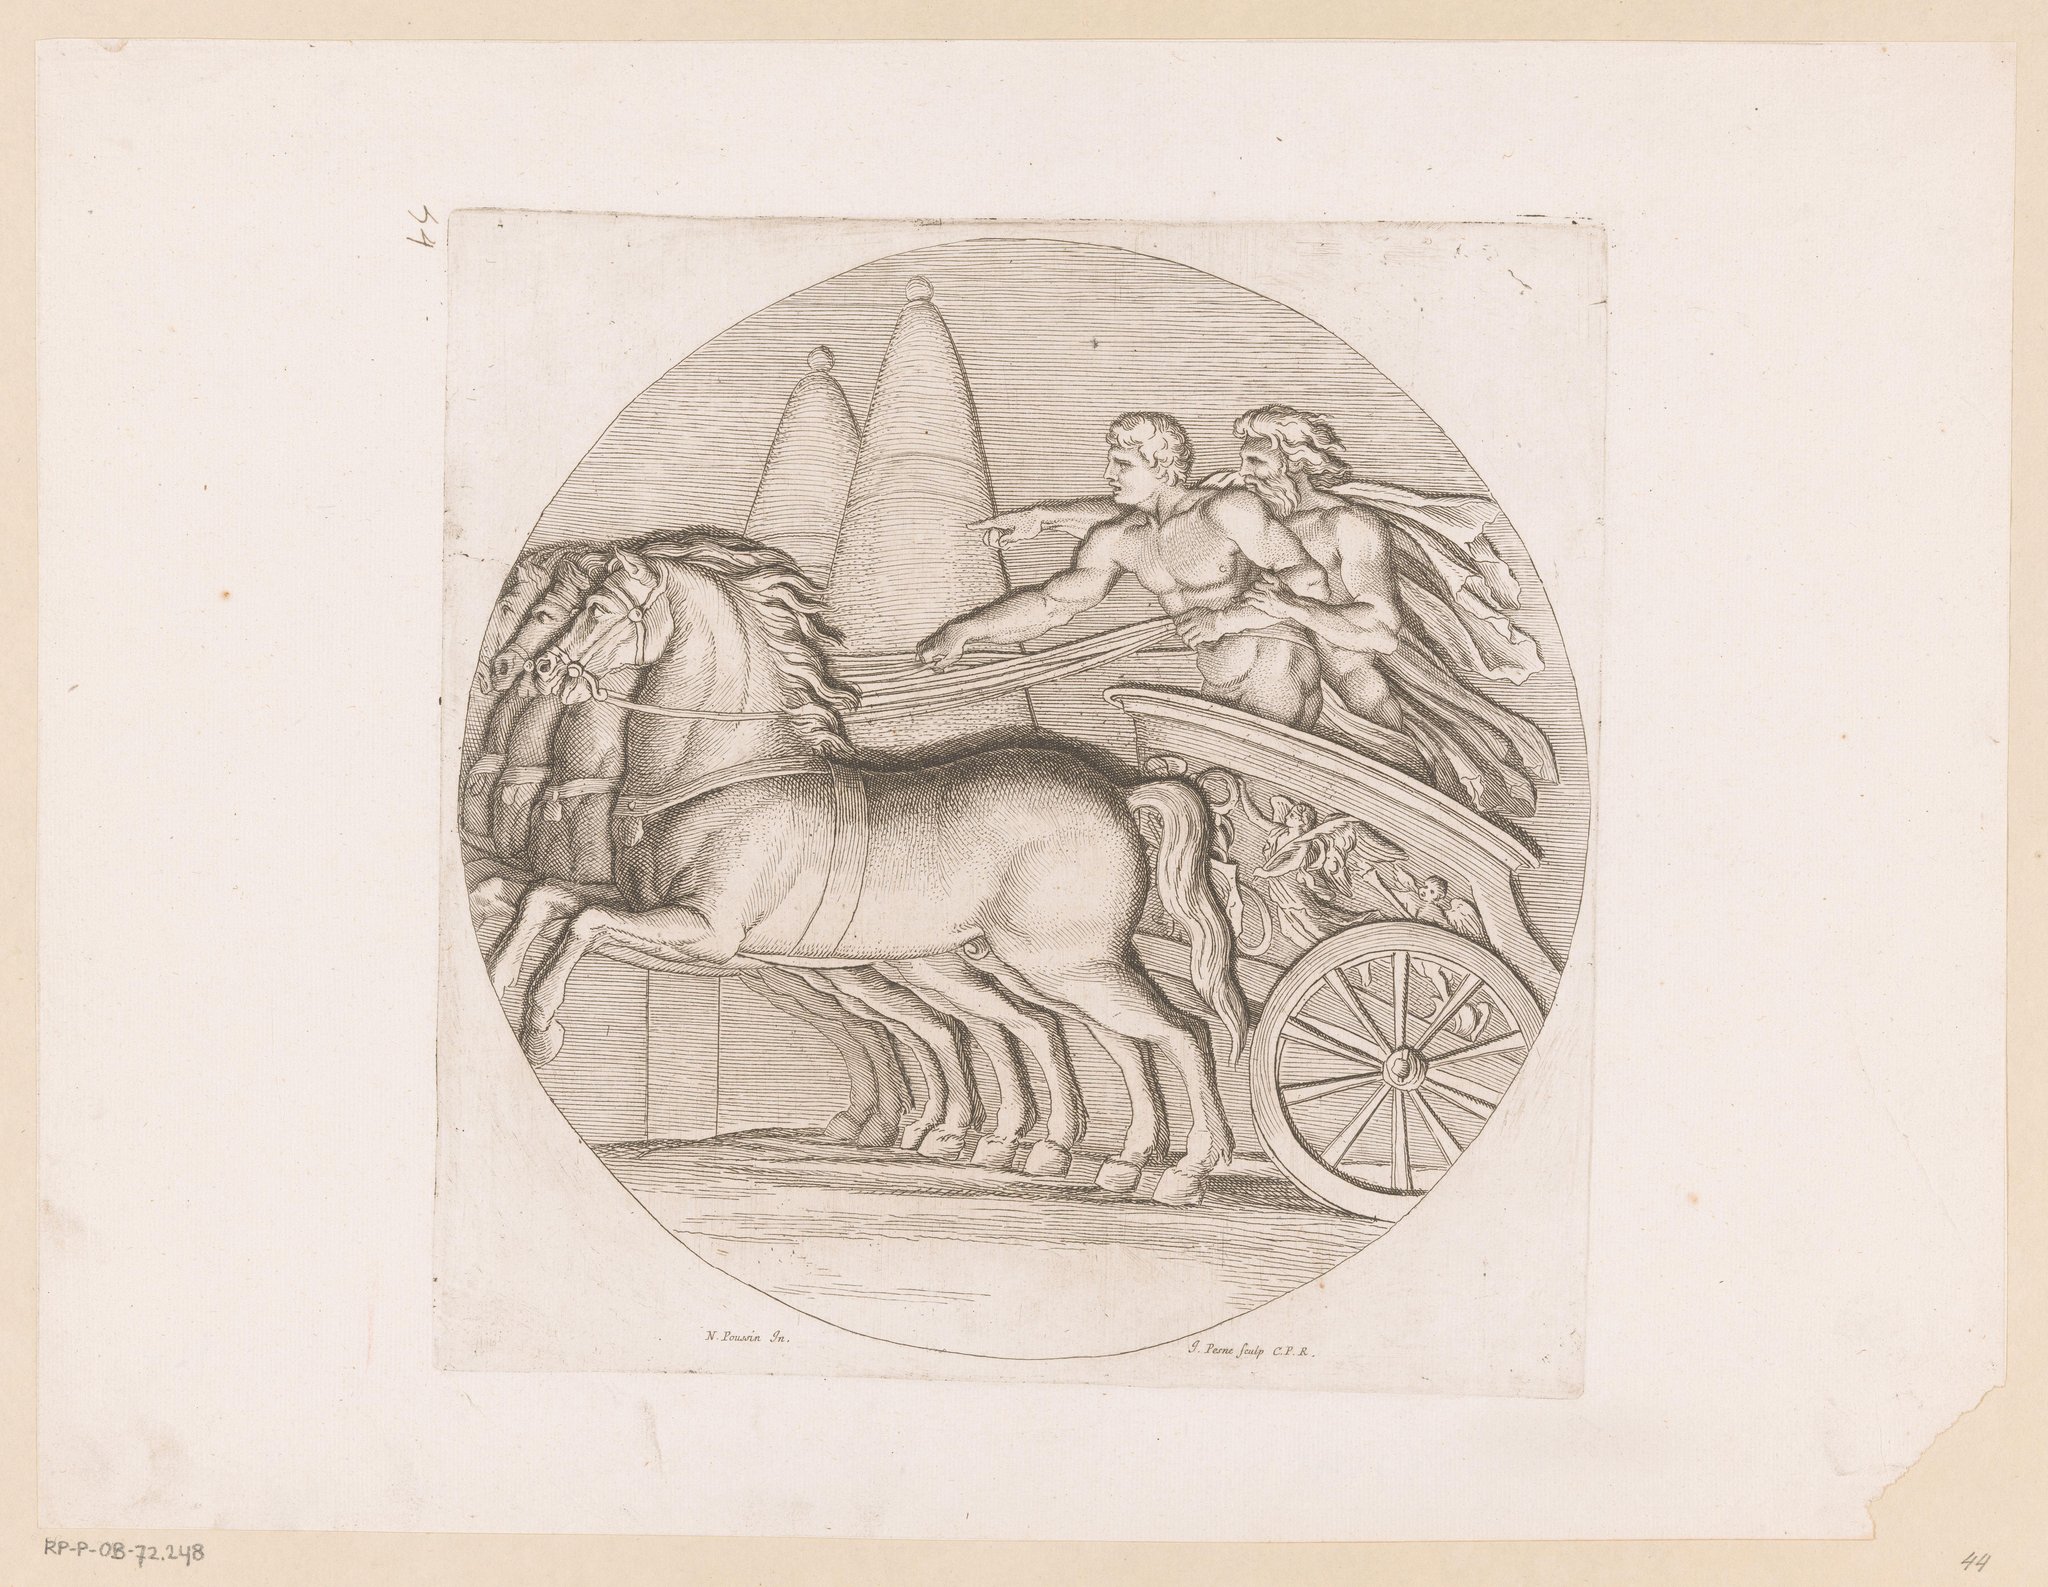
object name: print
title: Hercules op strijdwagen met vier paarden ervoor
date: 1678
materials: paper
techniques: engraving, etching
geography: france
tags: (story of) hercules (heracles)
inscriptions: collector's mark: Lugt 240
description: Prent maakt deel uit van een ongenummerde serie van negentien prenten.